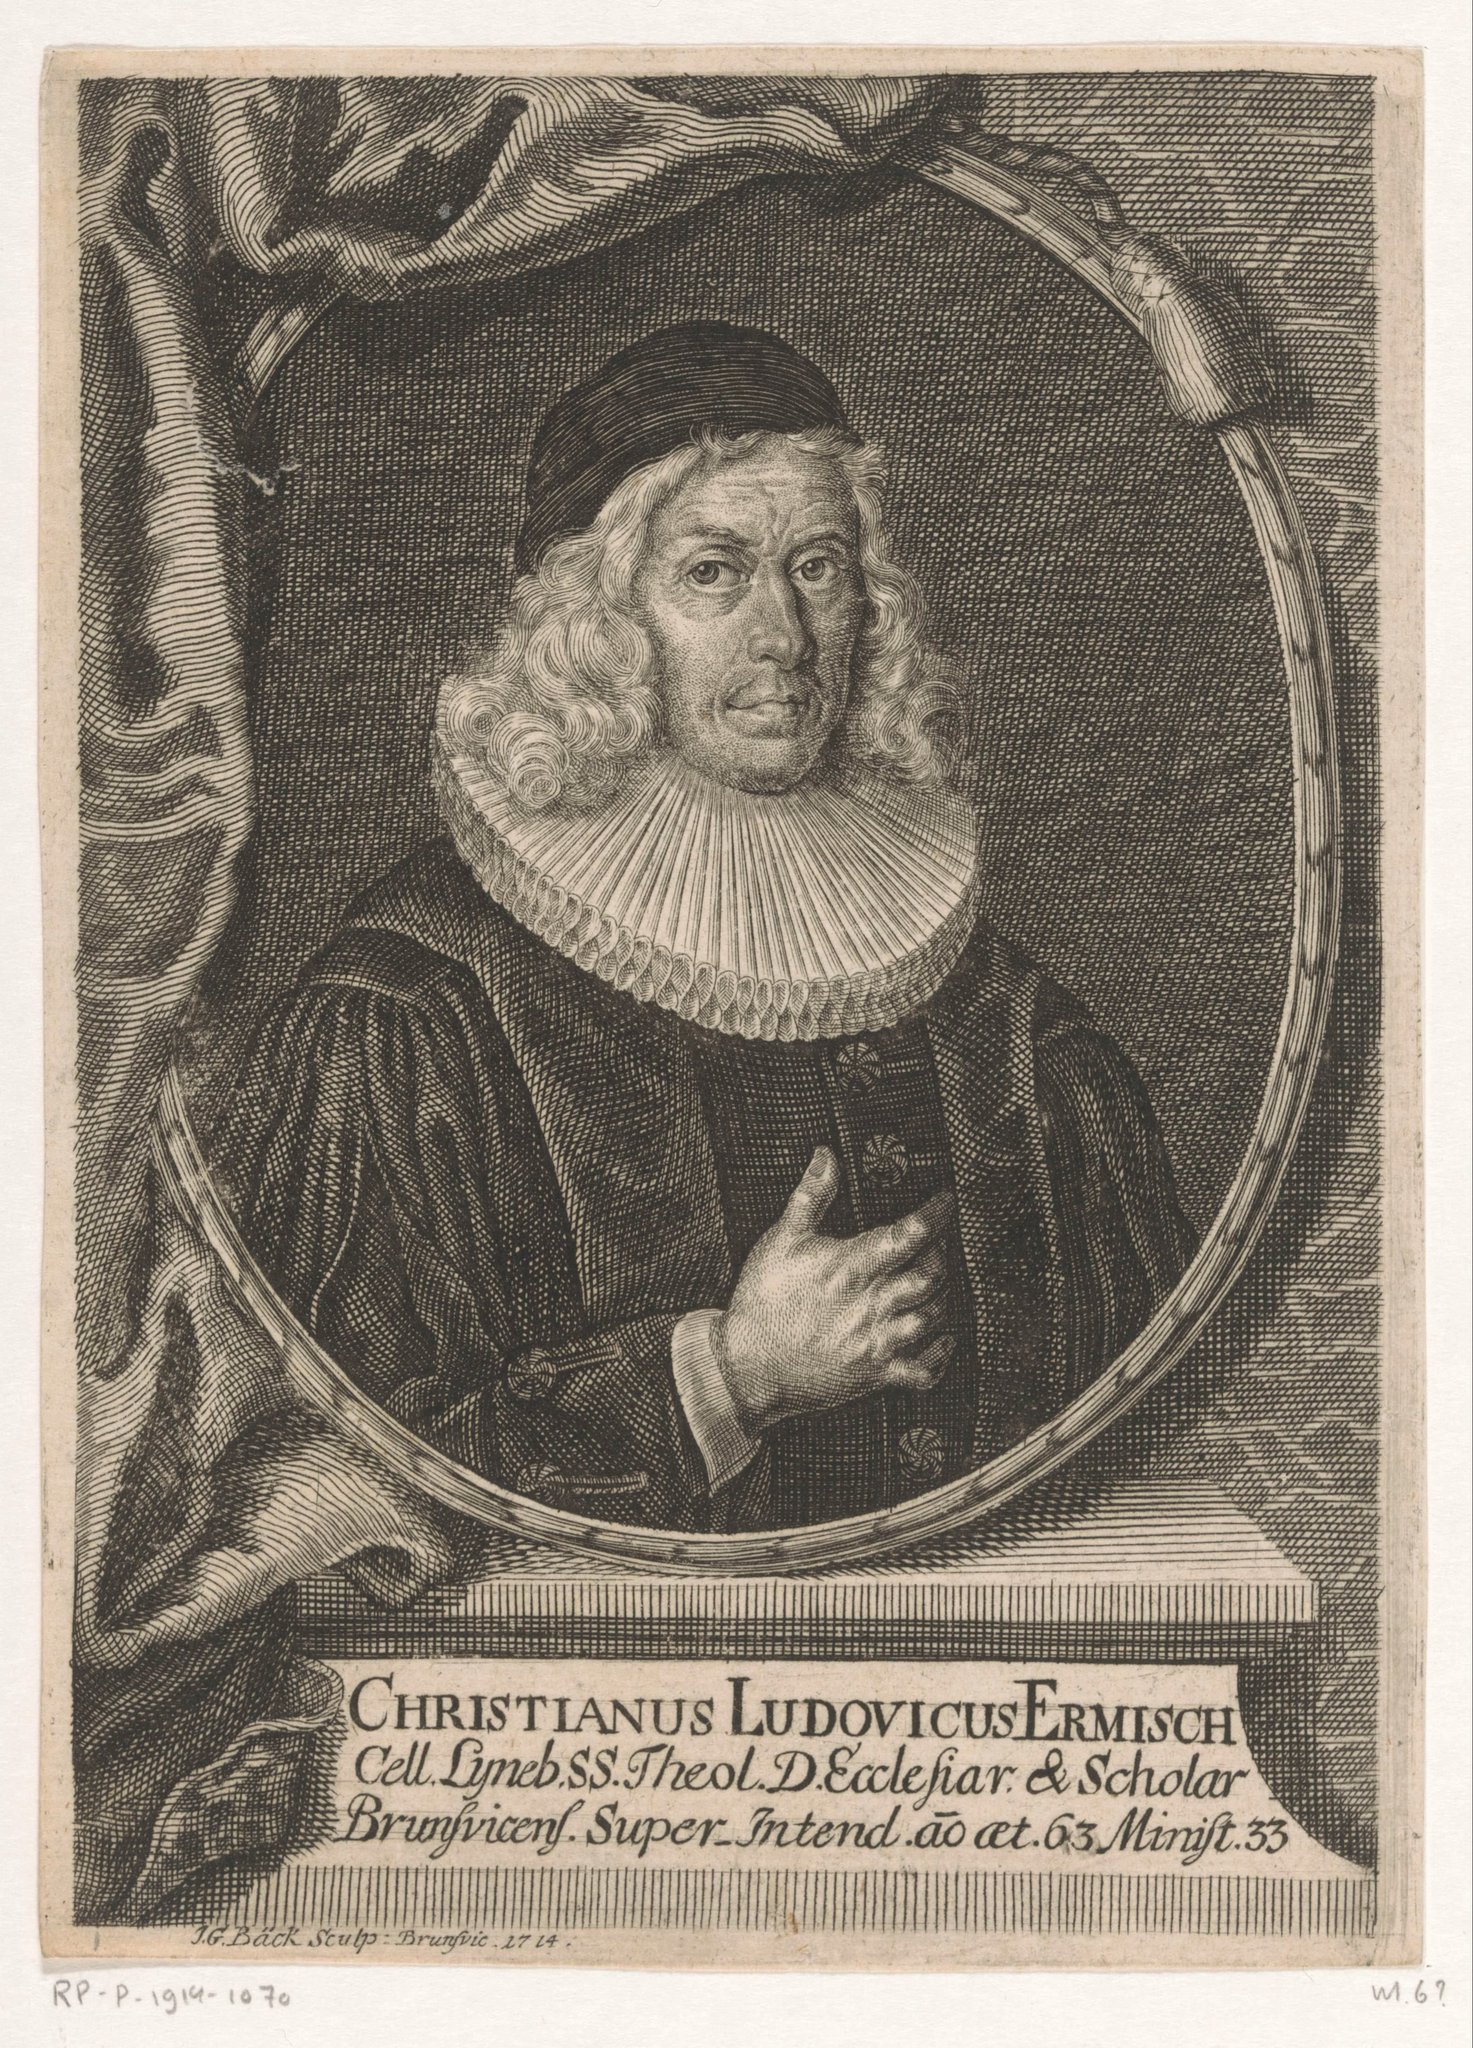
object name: print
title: Portret van Christian Ludwig Ermisch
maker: johann georg beck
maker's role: print maker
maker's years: 1676-1722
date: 1714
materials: paper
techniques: engraving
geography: braunschweig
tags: historical persons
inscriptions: collector's mark: Lugt 2228